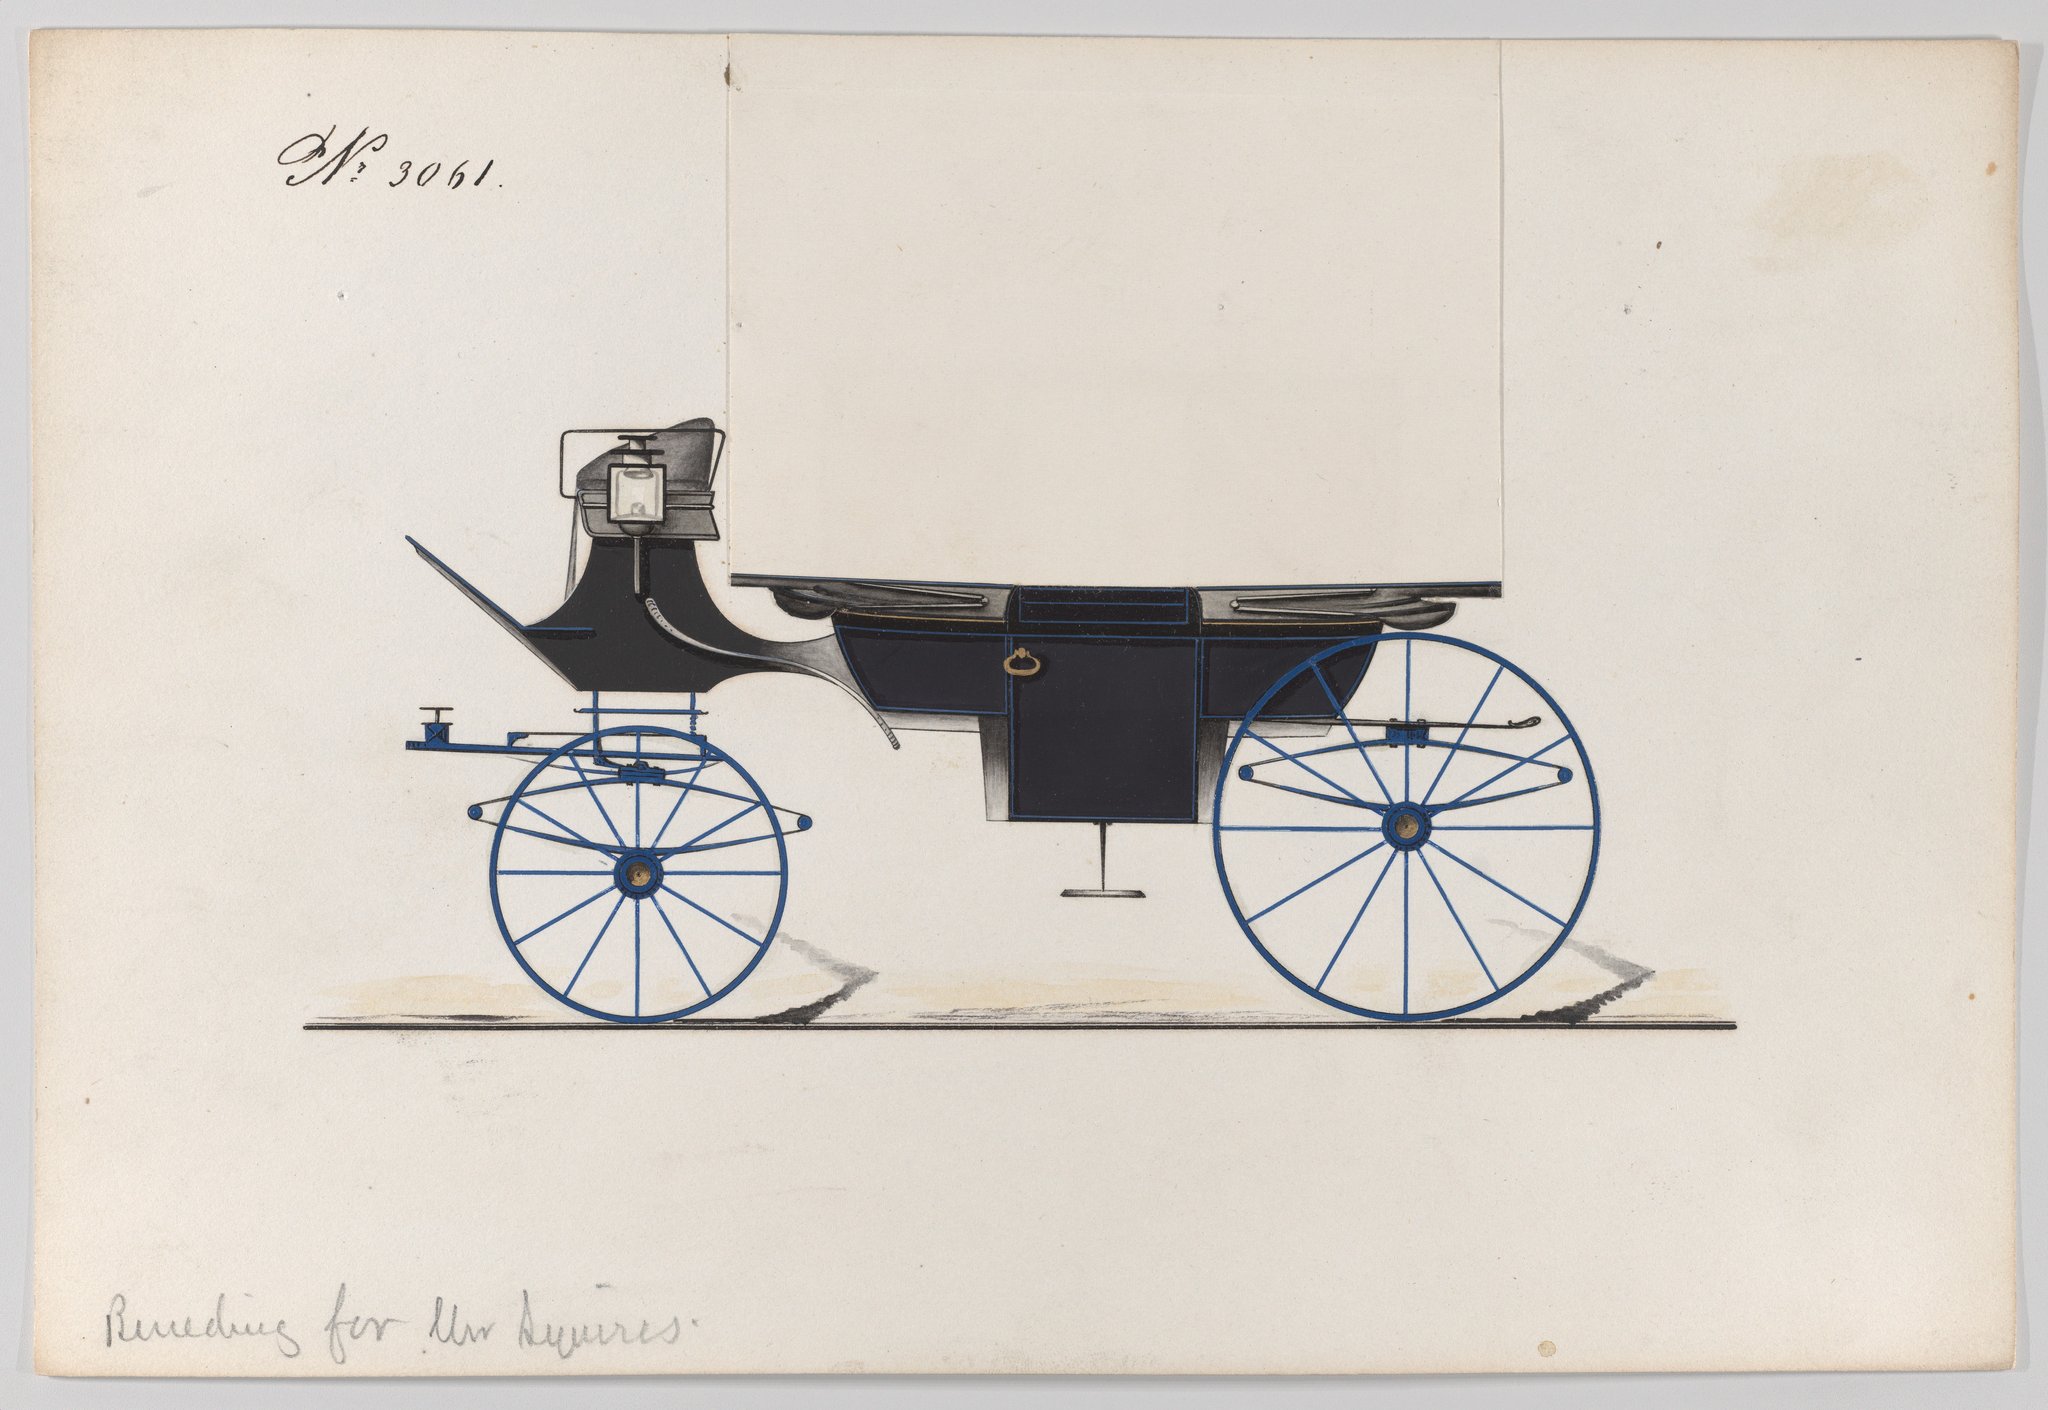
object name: drawing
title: Design for Landau, No. 3061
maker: brewster & co.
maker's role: manufacturer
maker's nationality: american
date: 1874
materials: gouache, gum arabic, ink, watercolor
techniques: pen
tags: carriages